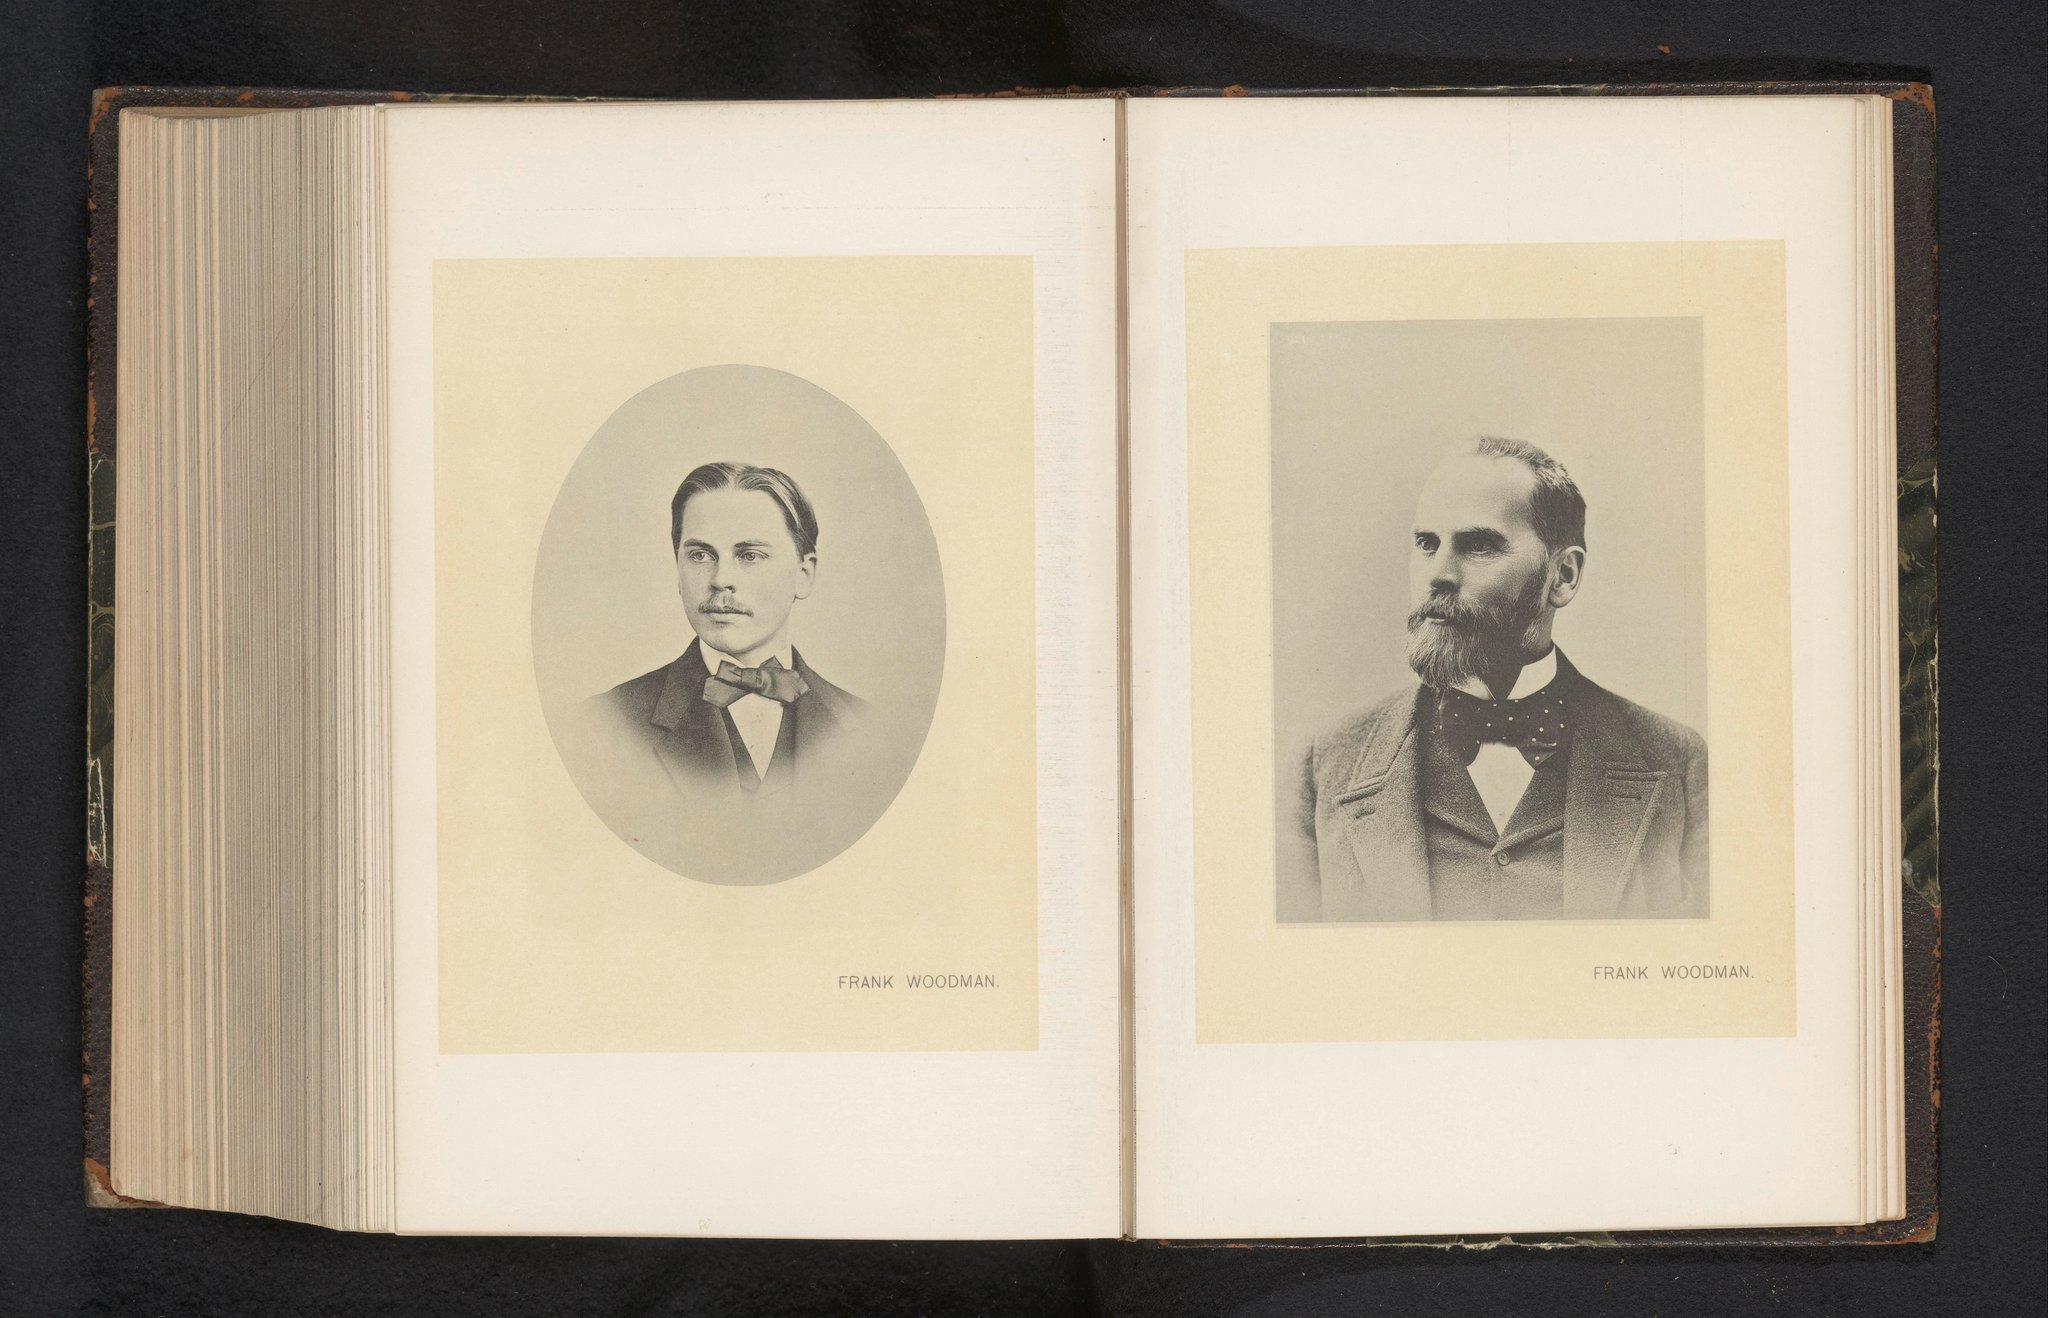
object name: photomechanical print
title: Frank Woodman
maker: Anonymous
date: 1889-1894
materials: paper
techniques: photoaquatint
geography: boston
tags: adult man